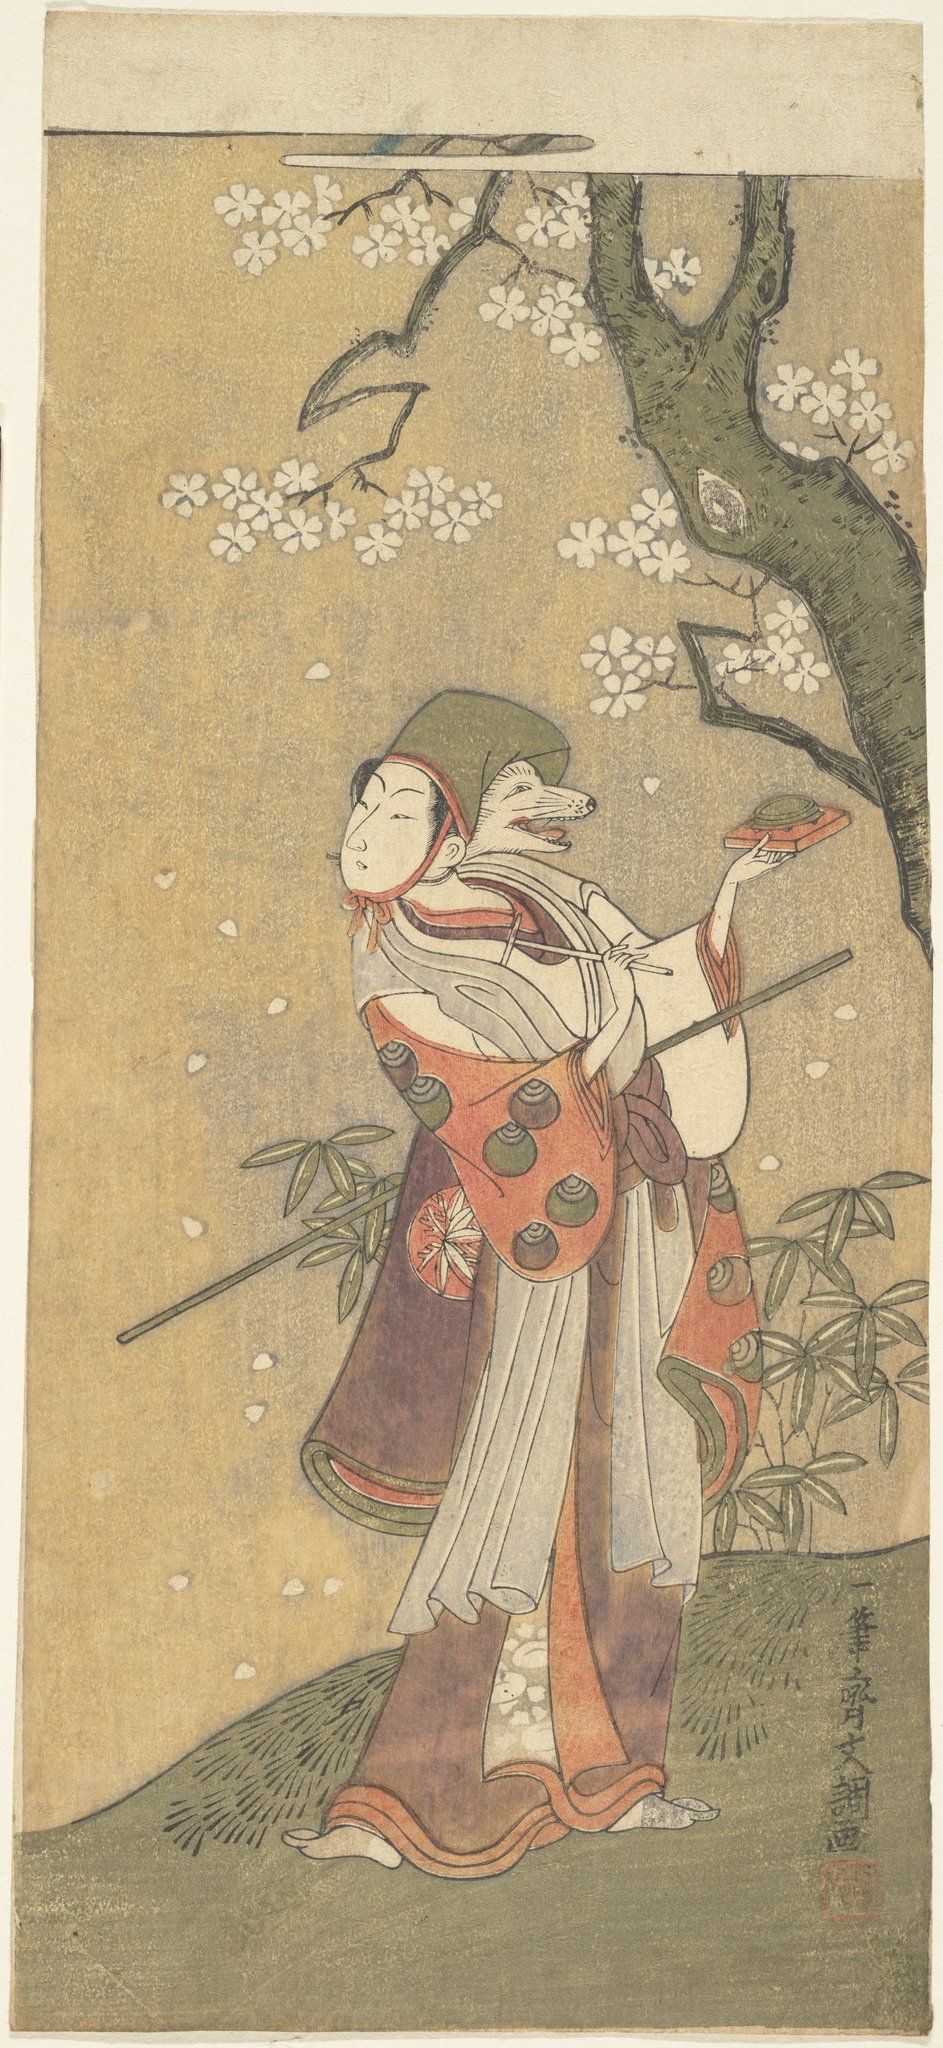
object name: woodblock print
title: An Actor in the Fox Dance from the Drama, "The Thousand Cherry Trees"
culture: japanese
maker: ippitsusai bunchō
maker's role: artist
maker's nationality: japanese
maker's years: 1765-1792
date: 1723-1792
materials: ink, paper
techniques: woodblock print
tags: dance,flowers,trees,actors